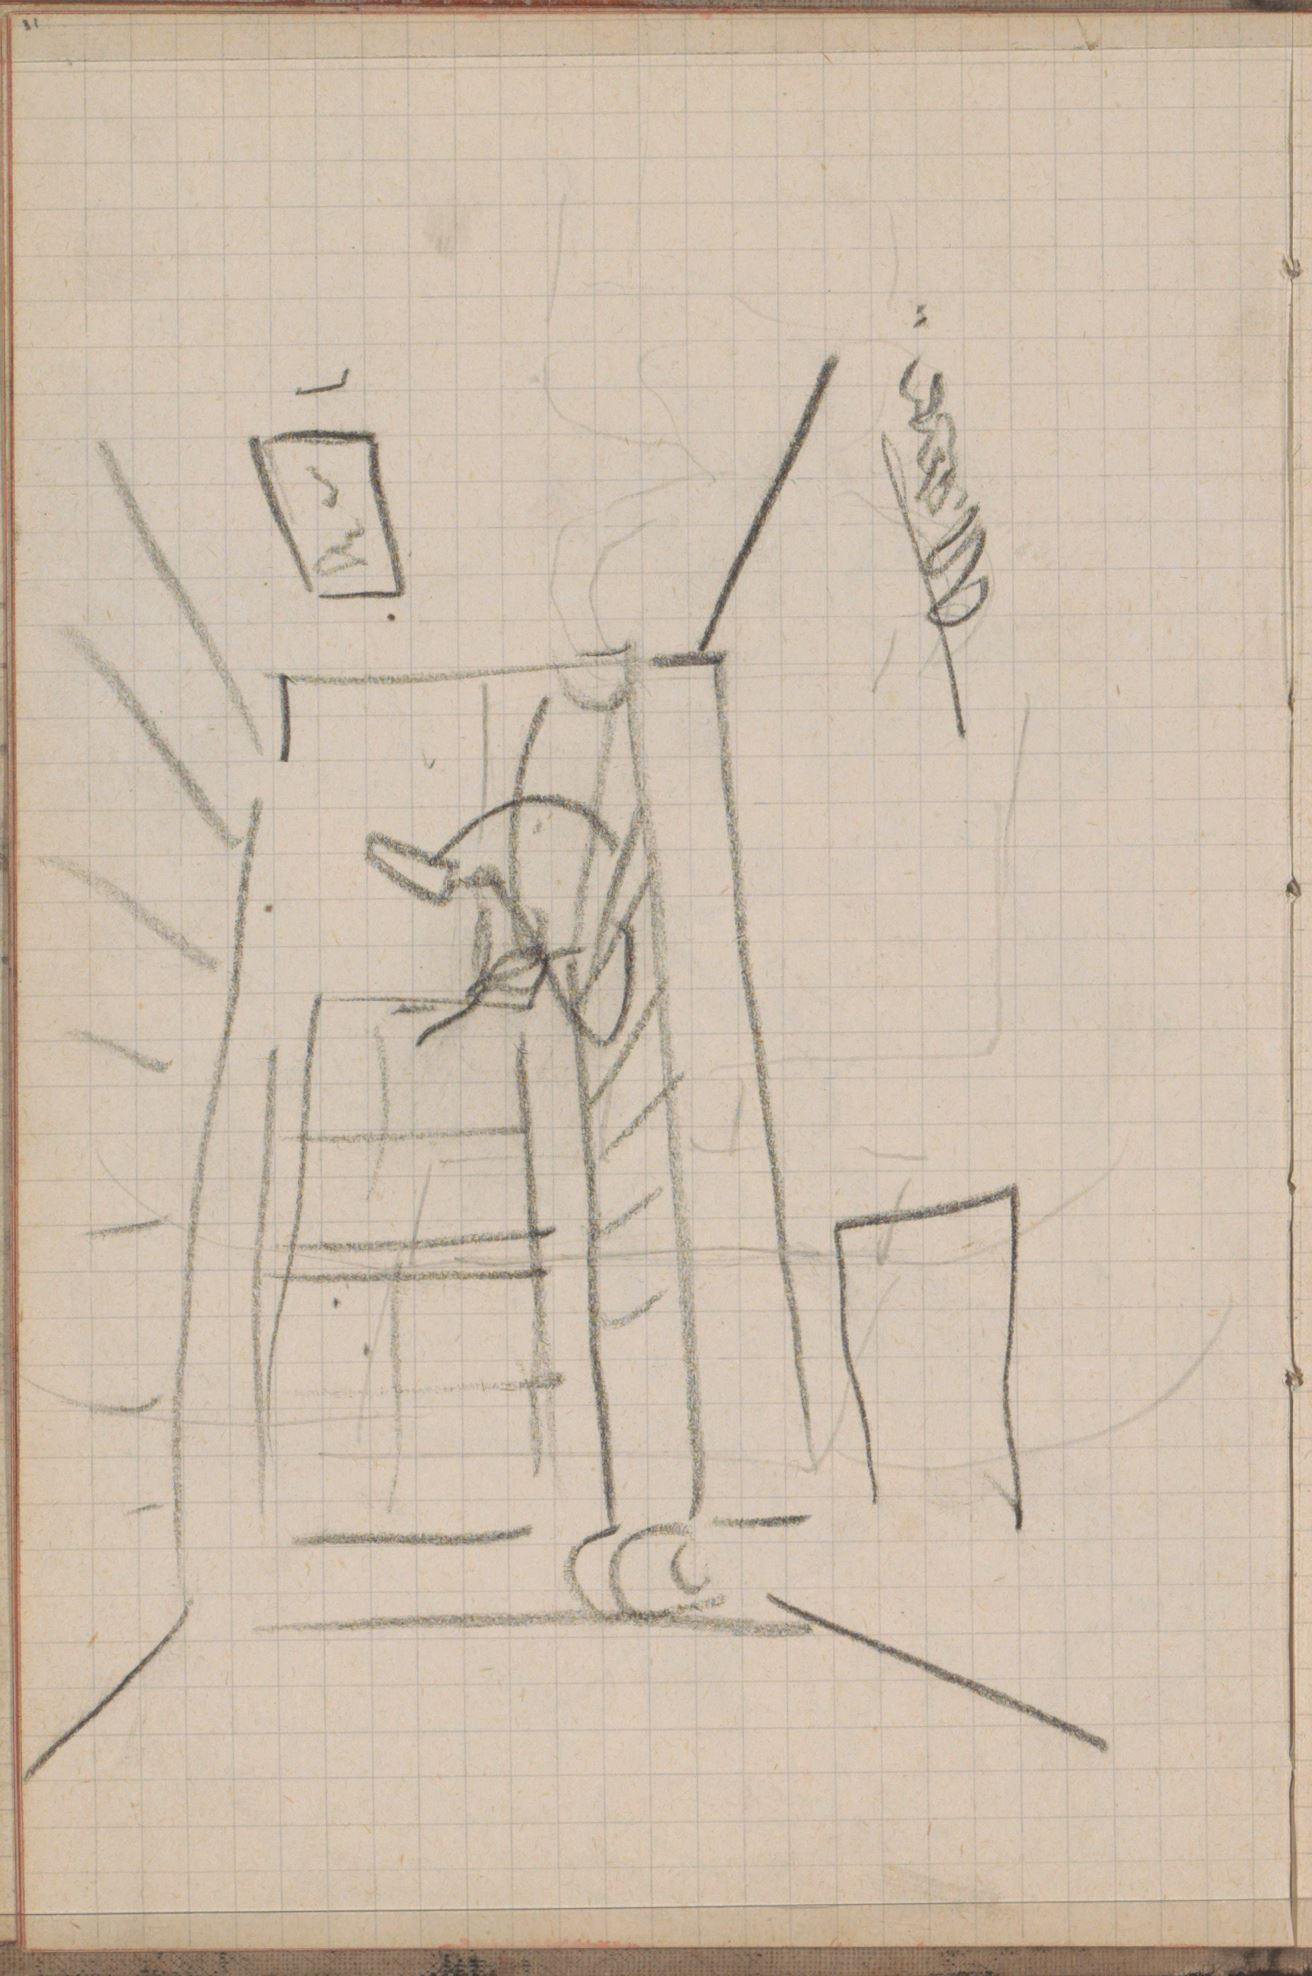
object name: sketchbook leaf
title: Zittende figuur in een interieur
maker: marius bauer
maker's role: draughtsman, print maker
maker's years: 1867-1932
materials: chalk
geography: istanbul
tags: sitting figure, interior of the house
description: Pagina 31 uit een schetsboek met 54 bladen.